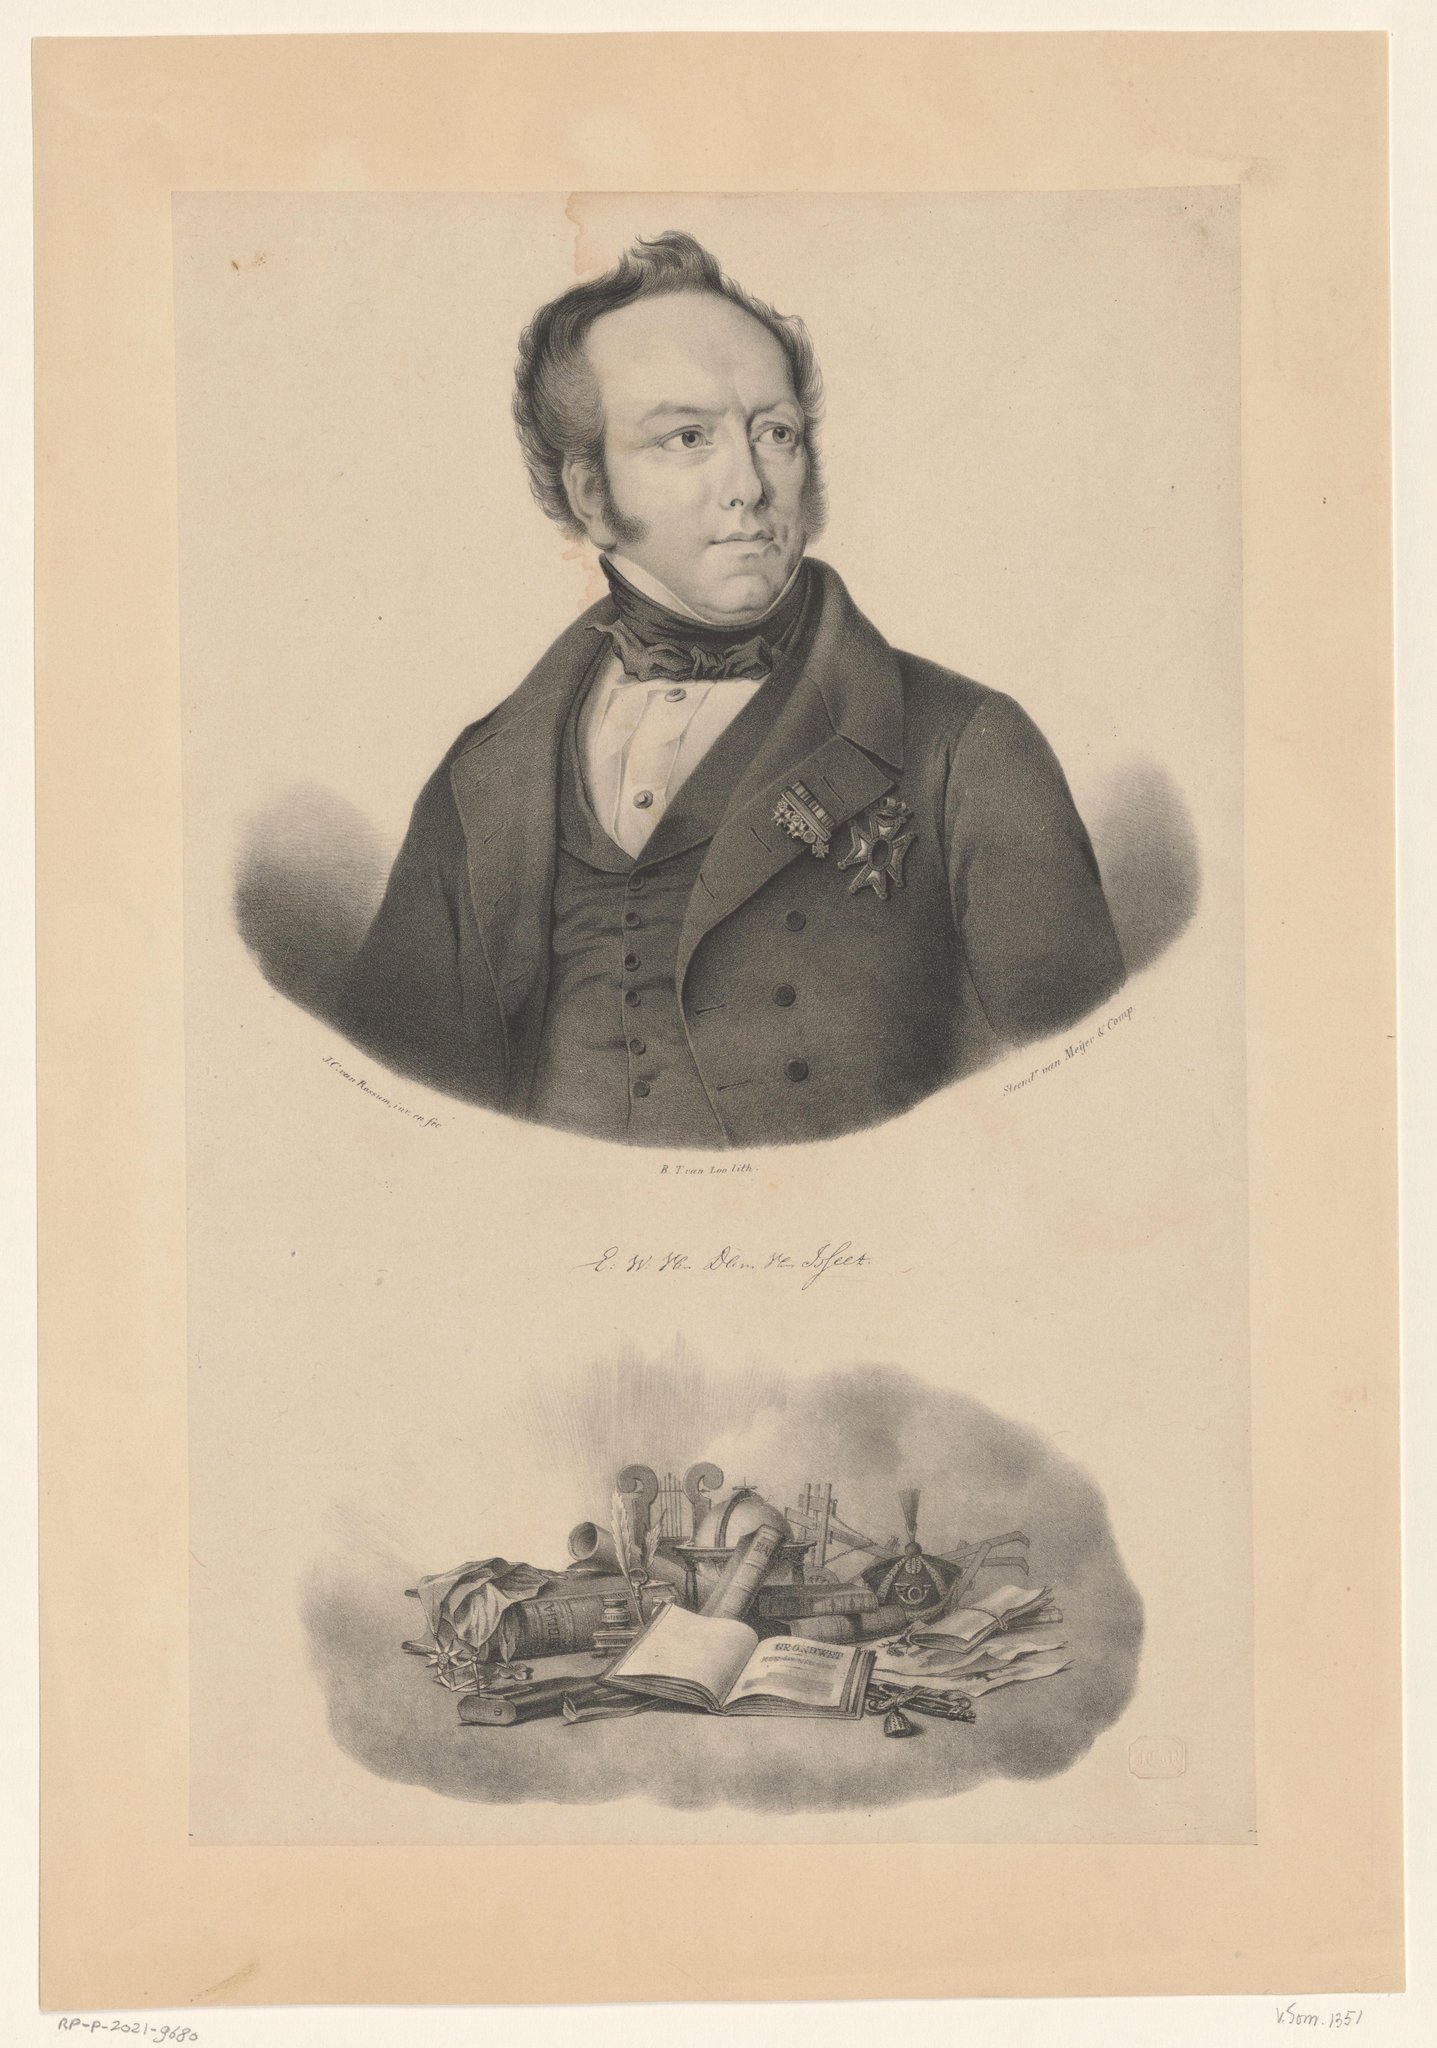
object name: print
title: Portret van Edmond Willem van Dam van Isselt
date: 1843-1856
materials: paper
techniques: lithograph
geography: amsterdam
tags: knighthood order, historical persons, weapons, book - mm - book open, string instruments (plucked), globe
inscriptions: check stamp: ‘JC v. R.’, collector's mark: Lugt 2228